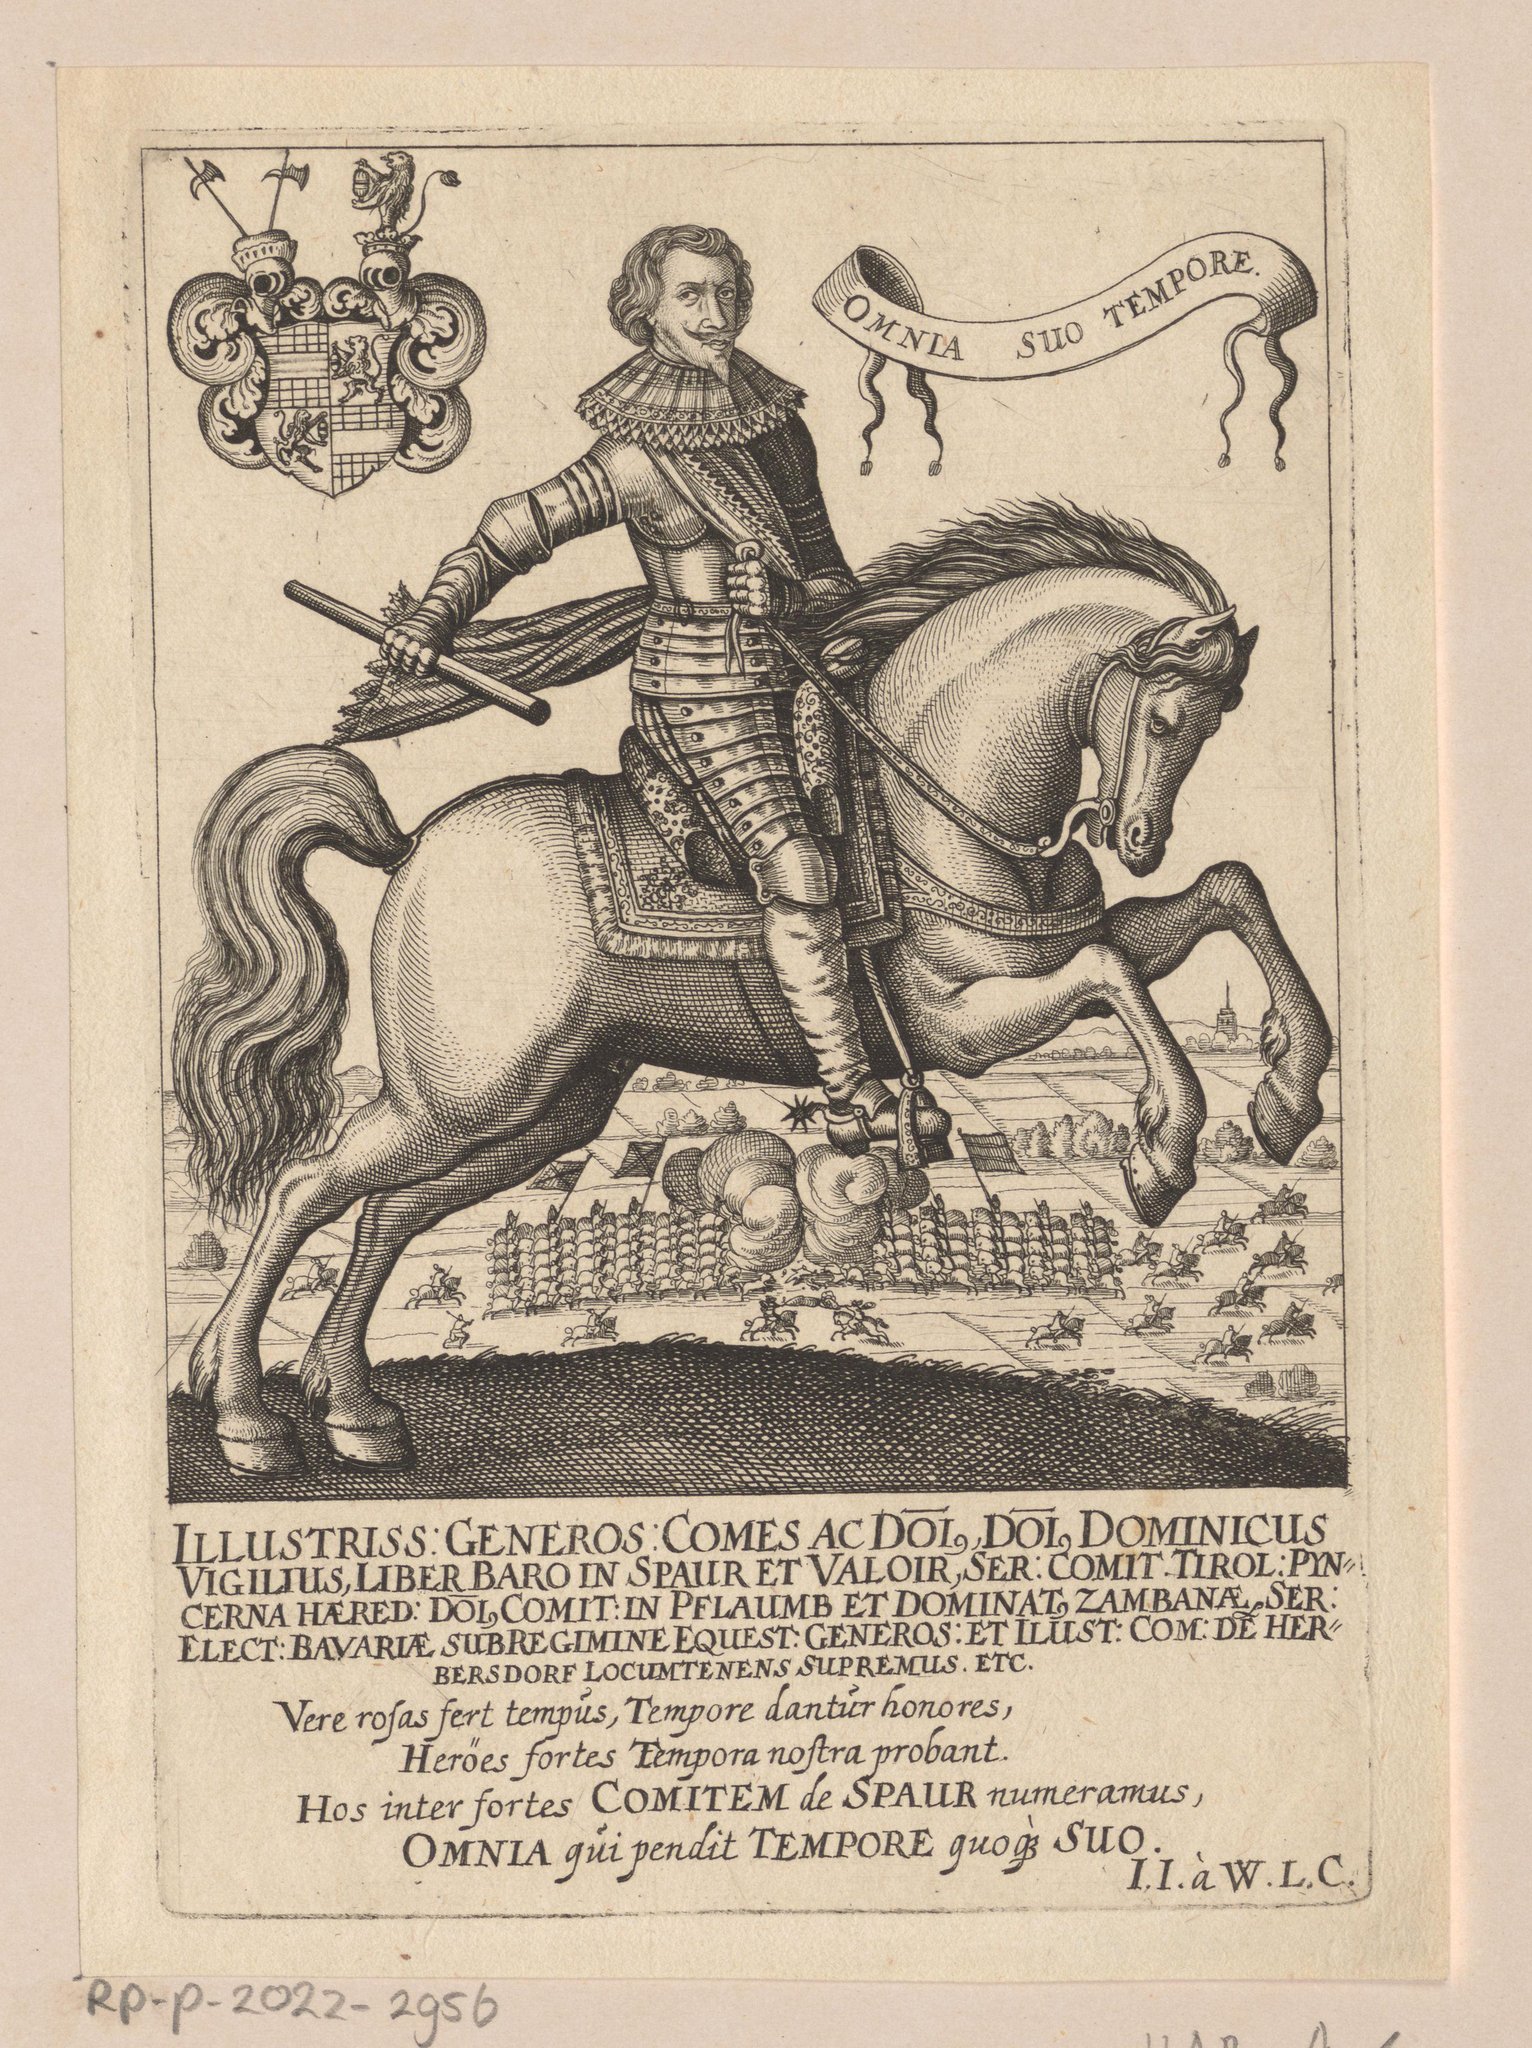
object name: print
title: Portret van Dominikus Vigilius von Spaur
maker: Anonymous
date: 1609-1750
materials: paper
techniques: etching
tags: politician, historical persons, politician, e.g. party leader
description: Met negenregelig onderschrift in het Latijn.